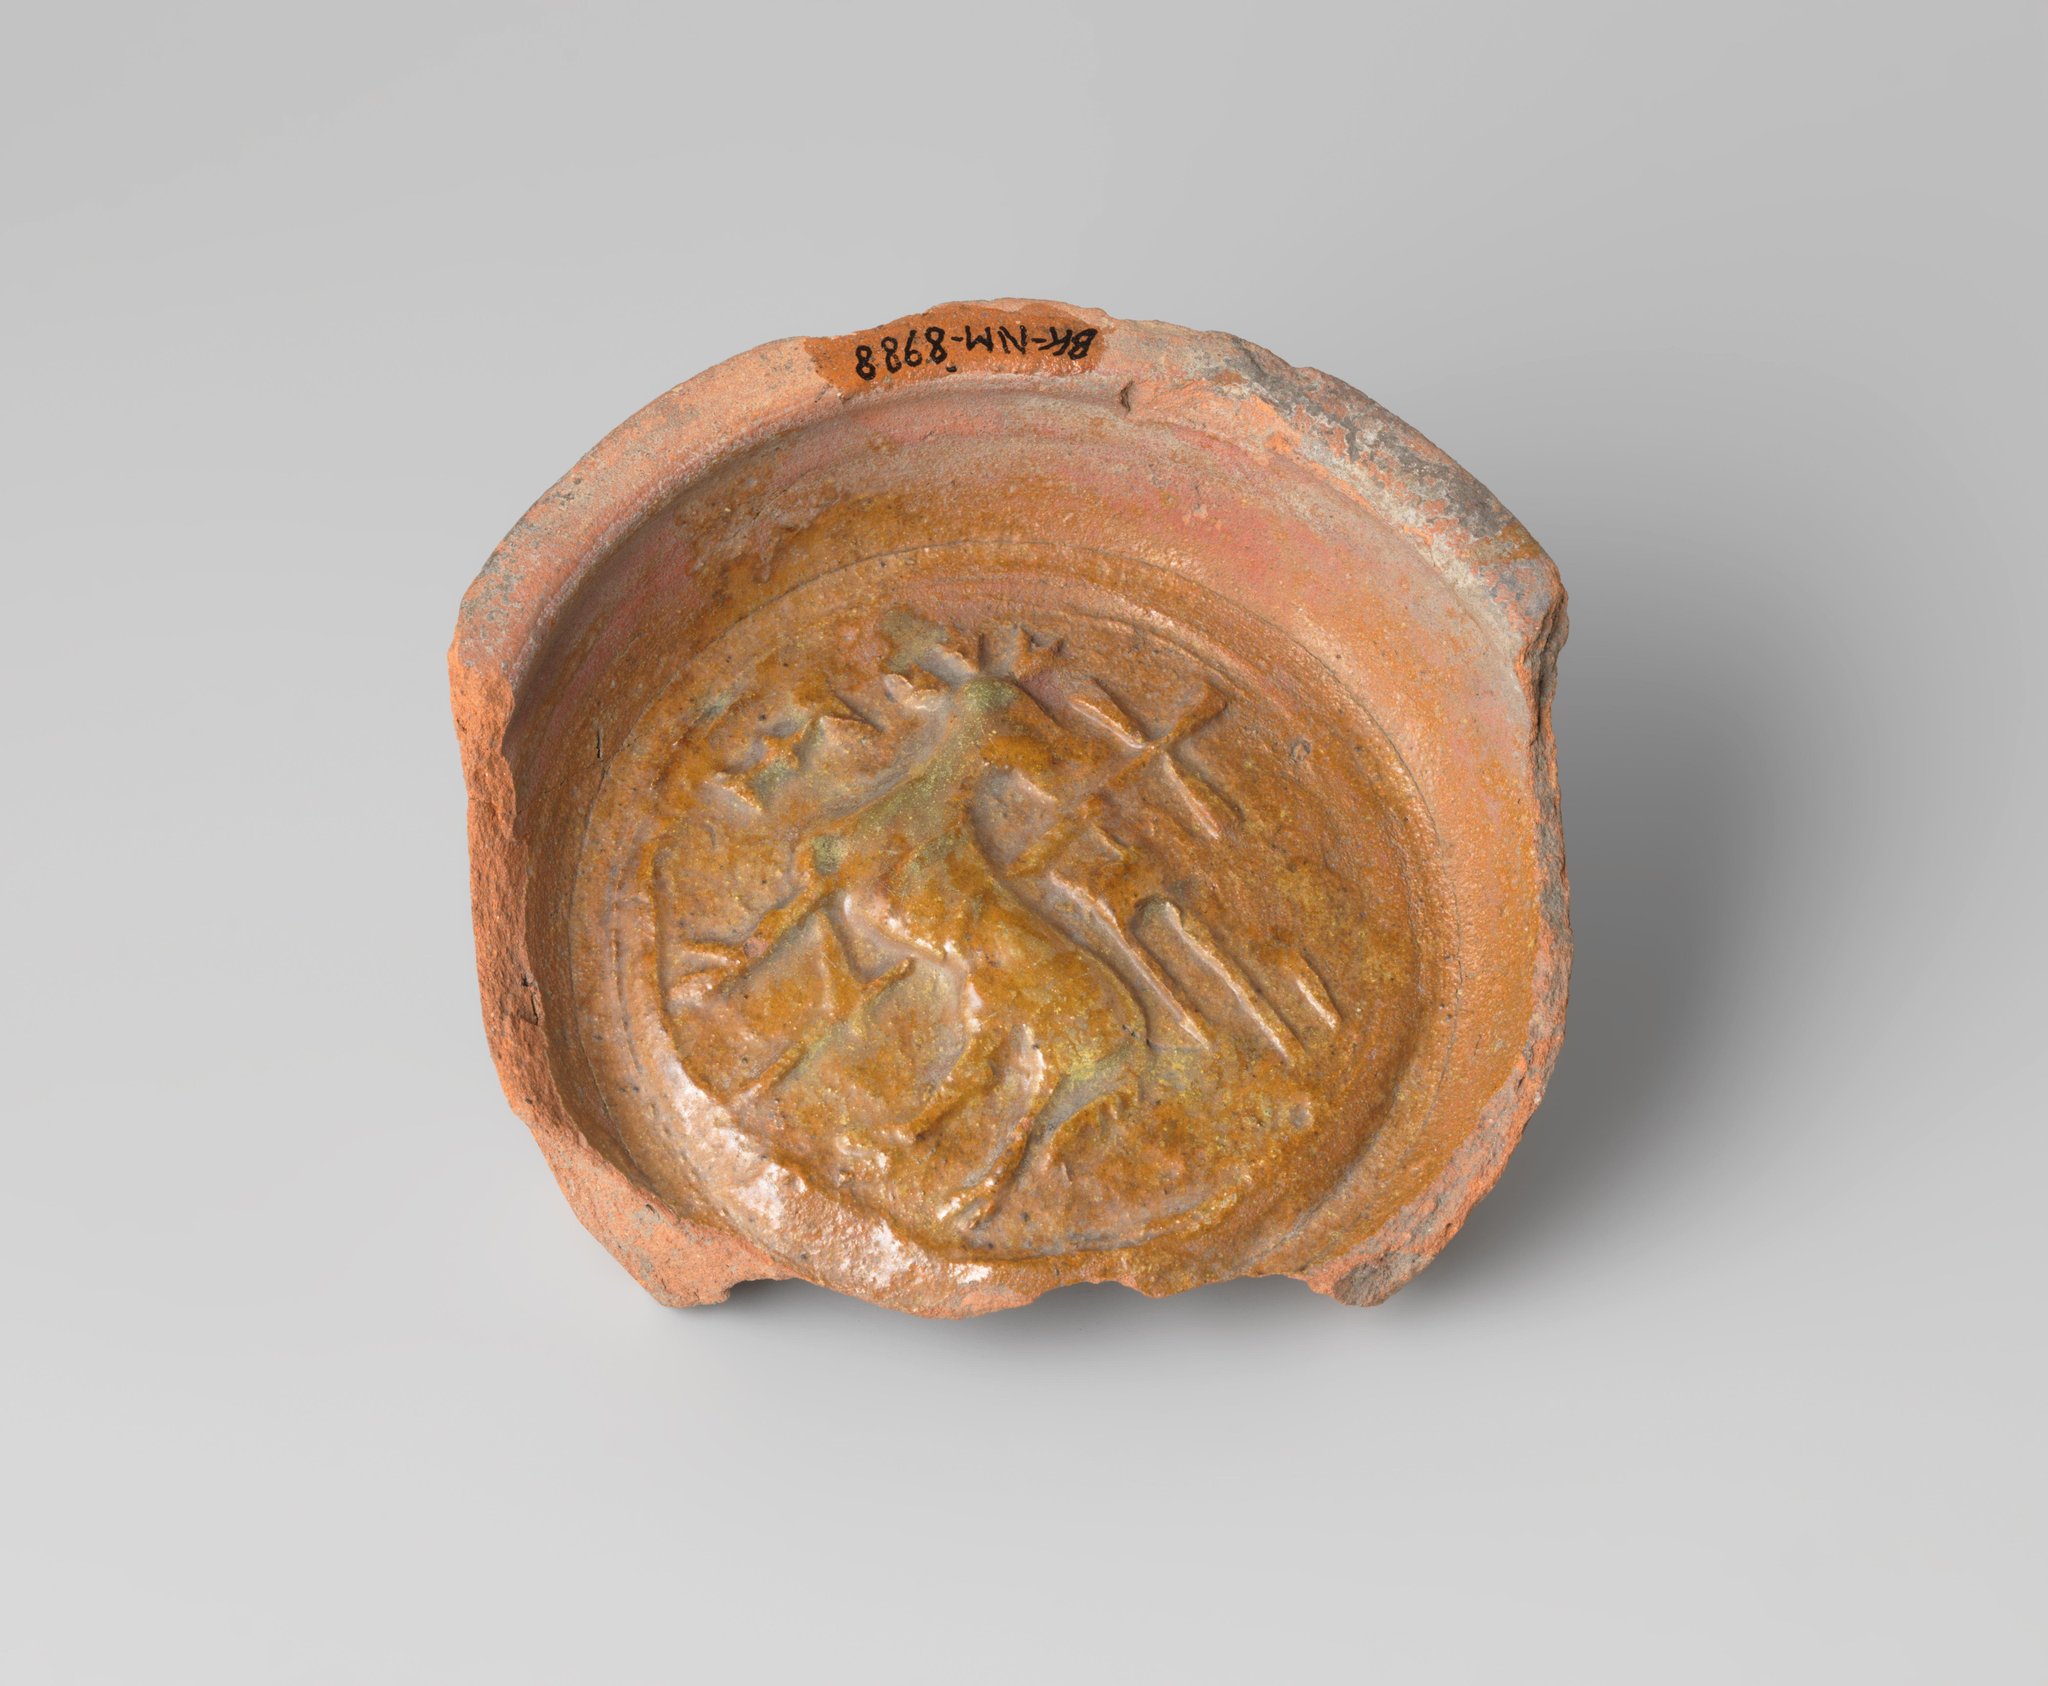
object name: base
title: Voetstuk of bak van loodglazuur aardewerk, fragment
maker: Anonymous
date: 1550-1600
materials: earthenware, glaze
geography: germany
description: Voetstuk of bak van aardewerk met loodglazuur. Op de bodem een afbeelding van het Lam Gods.